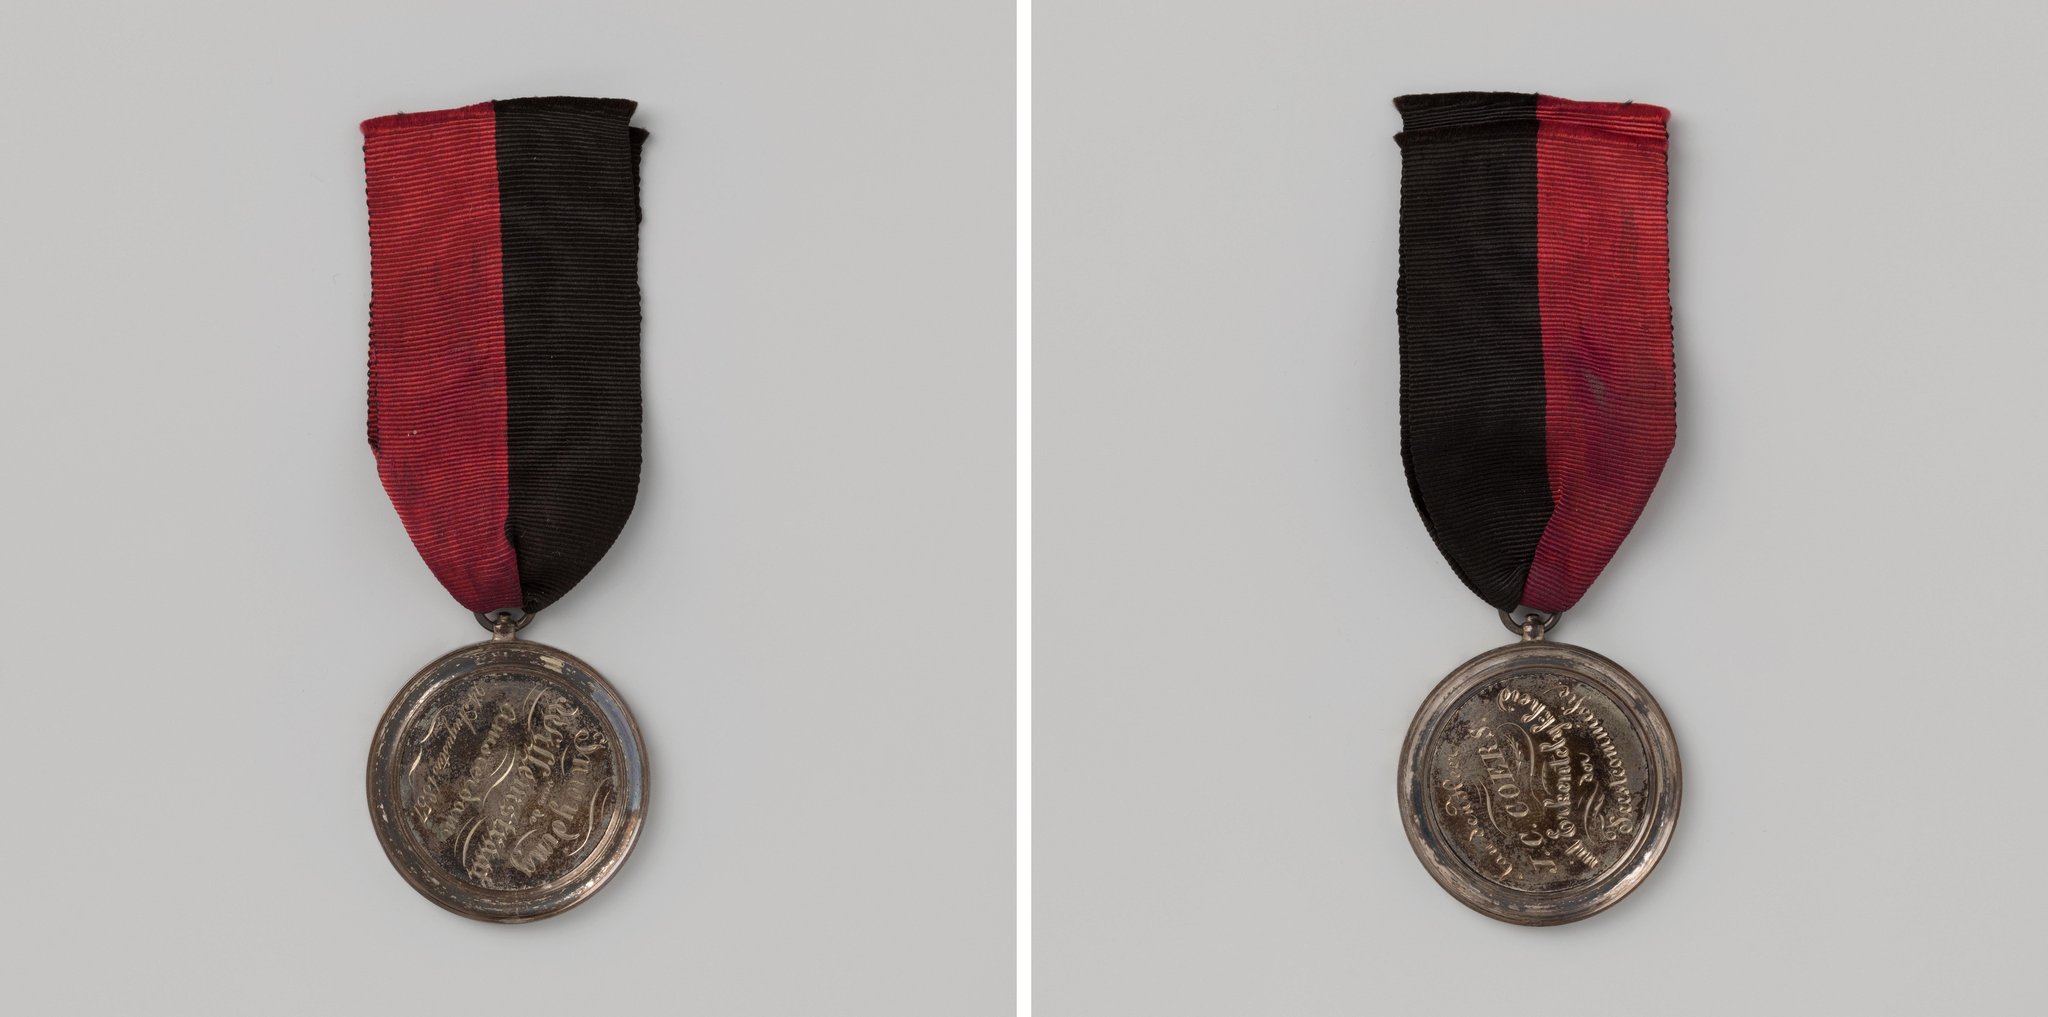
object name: history medal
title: Inwijding van de Willemsstraat te Amsterdam 1857, erkentenis aan J.C. Coen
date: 1857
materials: silver, textile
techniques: engraving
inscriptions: inscription: ‘Aan den Heer / J.C. COERS. / uit Erkentelijkheid / der / Feestcommissie’, inscription: ‘Inwijding / van de / Willemstraat / Amsterdam / 24 Augustus 1857.’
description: Zilveren draagpenning met versierde bal en draagoog aan rood-zwart lint, op voor- en keerzijde gegraveerde opschriften.